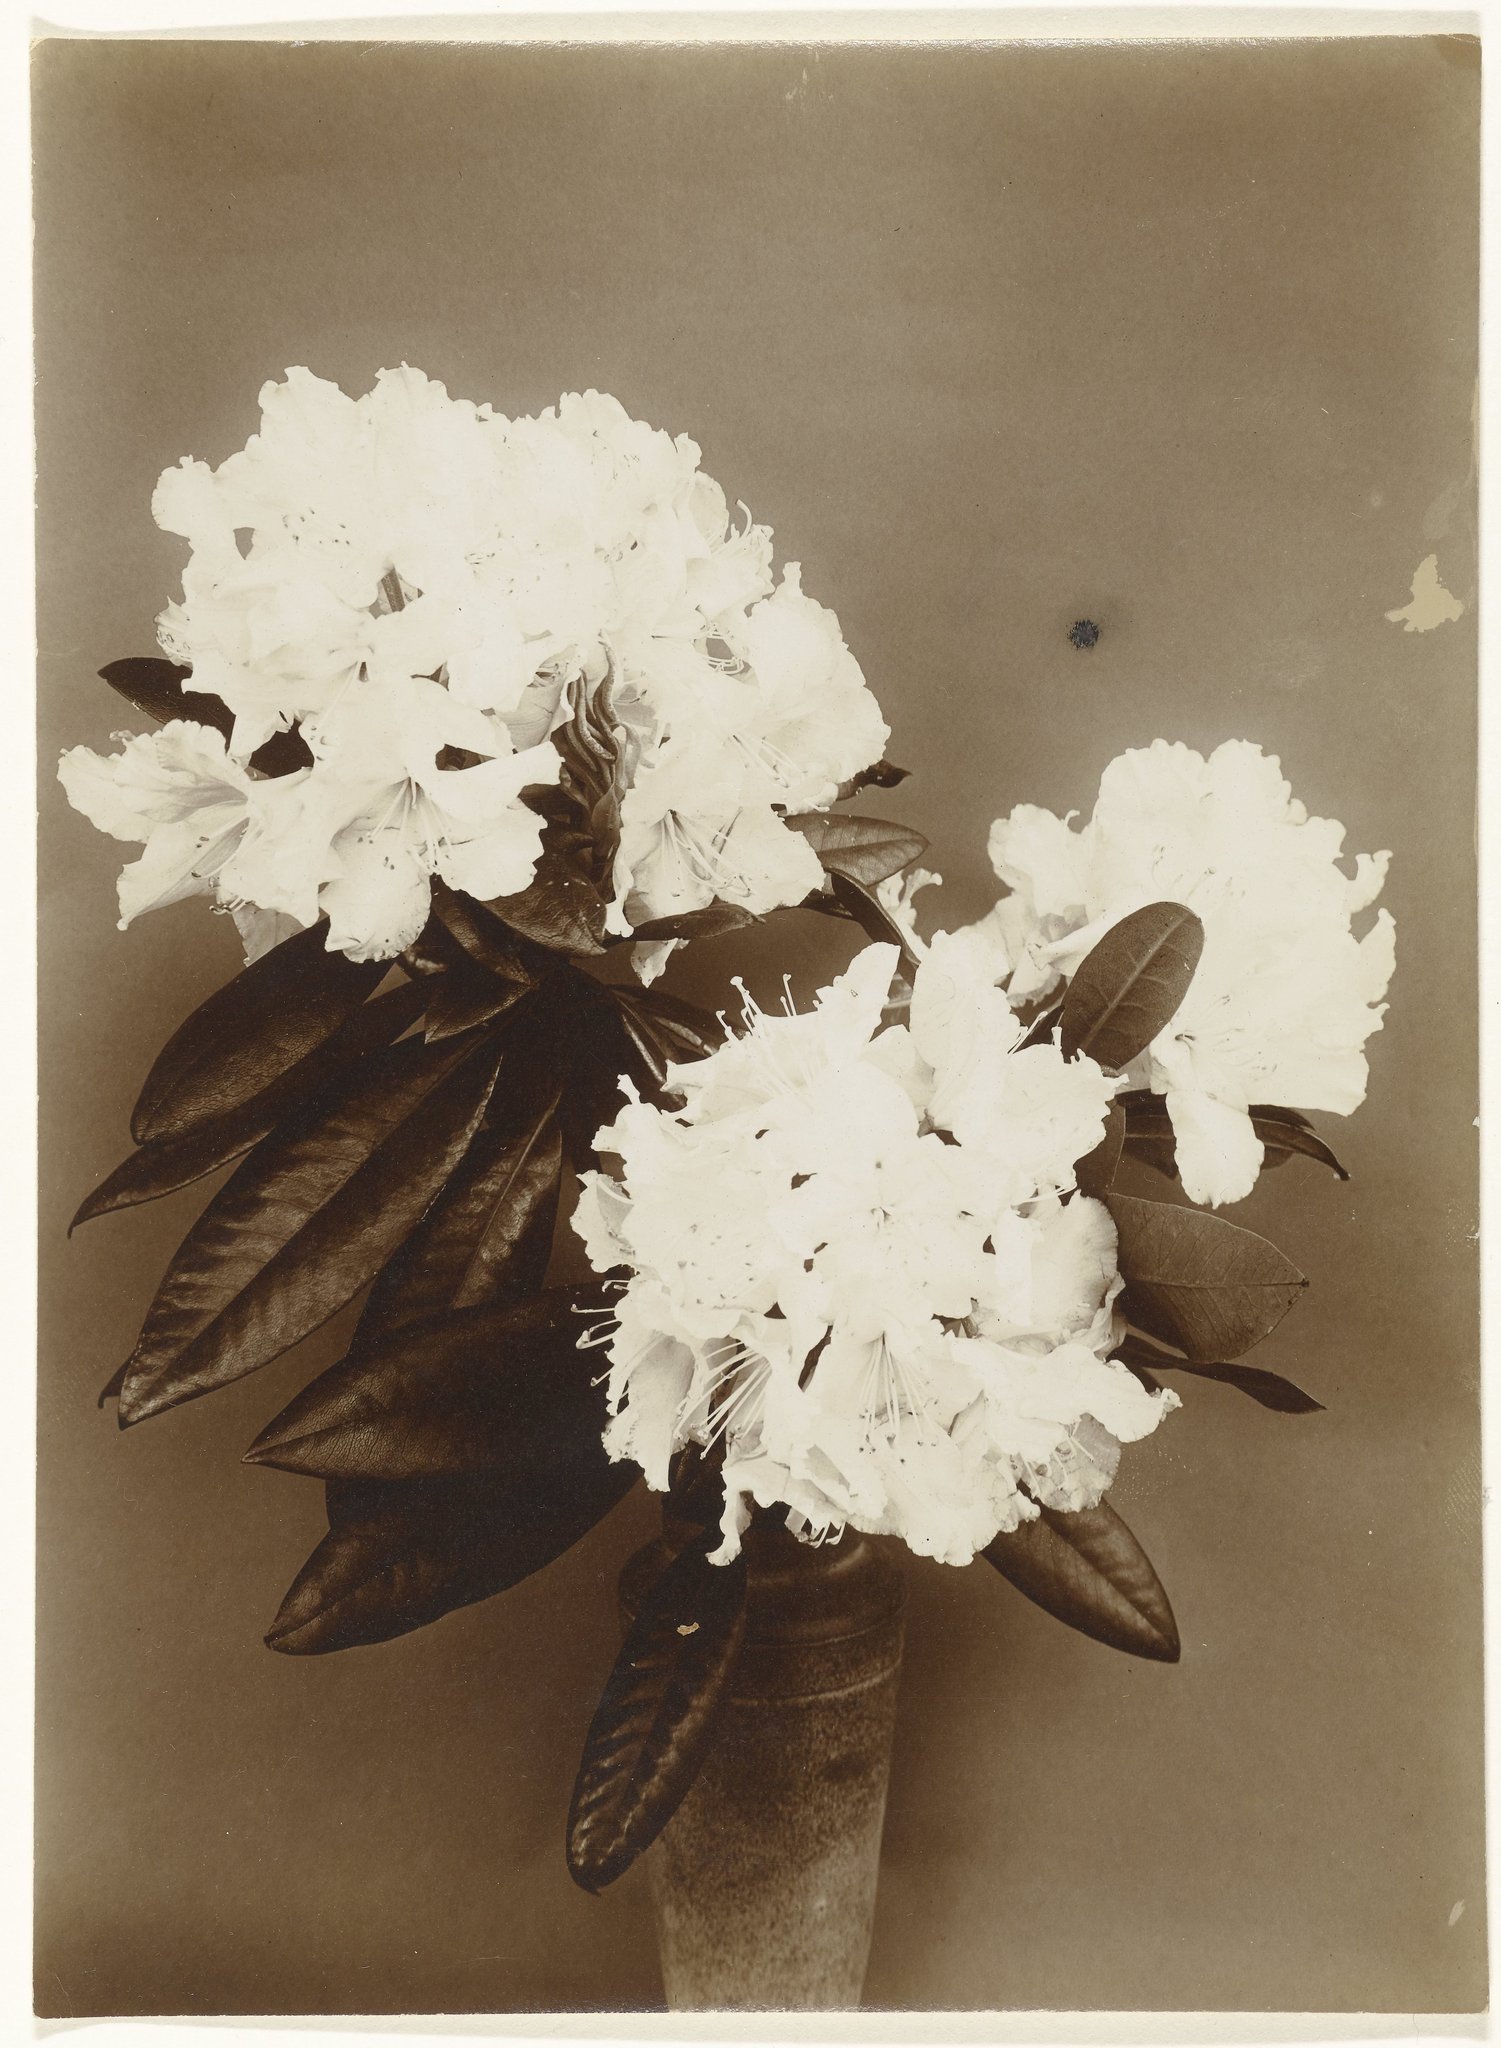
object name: photograph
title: Bloemen van de rhododendron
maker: richard tepe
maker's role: fotograaf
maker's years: 1864-1952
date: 1900-1930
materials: photographic support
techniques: gelatin silver print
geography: apeldoorn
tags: flowers in a vase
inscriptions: annotation: ‘Rhododendron Hybride / Urs Sterling [?] / in vaas’, signature: ‘foto / R Tepe / Apeldoorn / Holland’